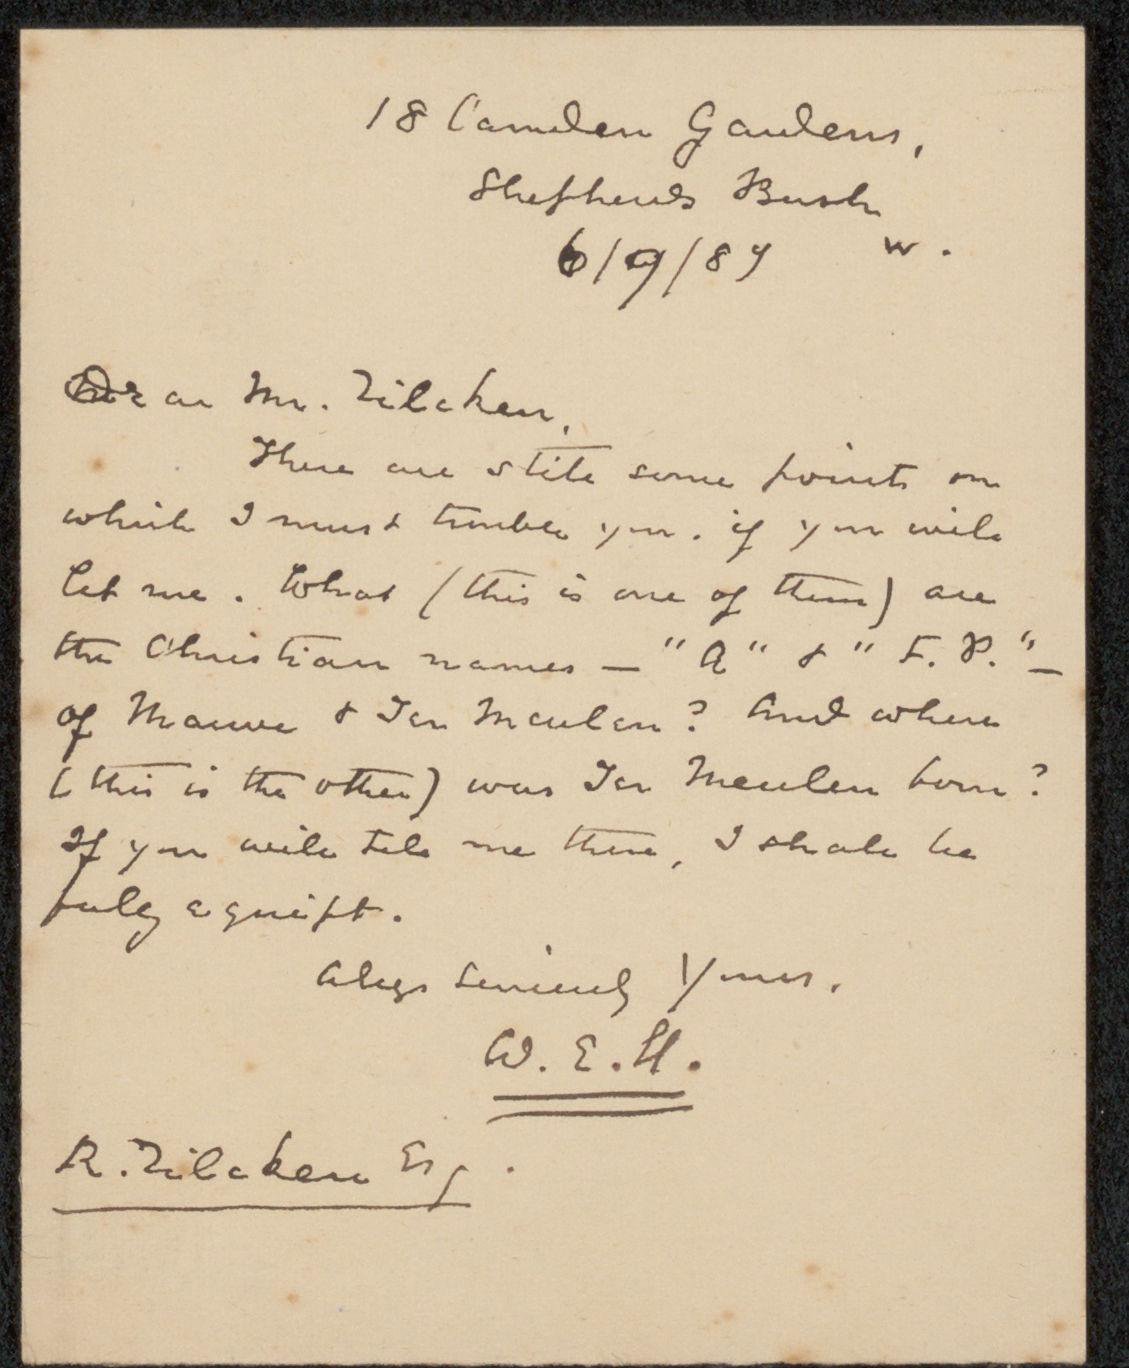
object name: letter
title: Brief aan Philip Zilcken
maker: william ernest henley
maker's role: criticus, dichter, redacteur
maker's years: 1849-1903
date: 1887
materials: ink, paper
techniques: pen, writing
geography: shepherd's bush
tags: bodegraven, the hague, painter, françois pieter ter meulen, arnhem, print maker, draughtsman, anton mauve, philip zilcken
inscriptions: collector's mark: ‘RPK’